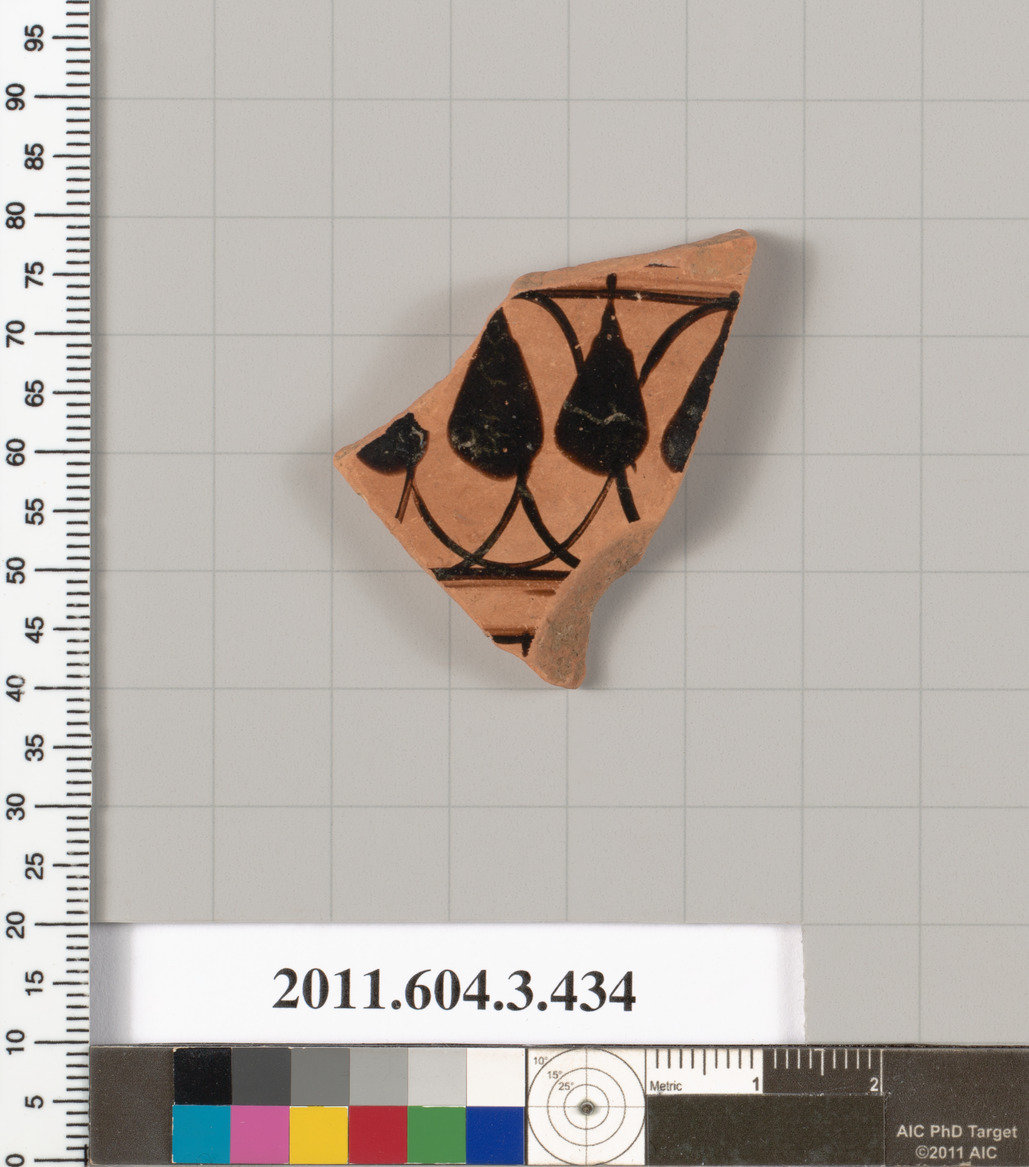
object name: neck amphora fragment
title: Terracotta fragment of a neck-amphora (jar)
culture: greek, attic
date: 520-510 BCE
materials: terracotta